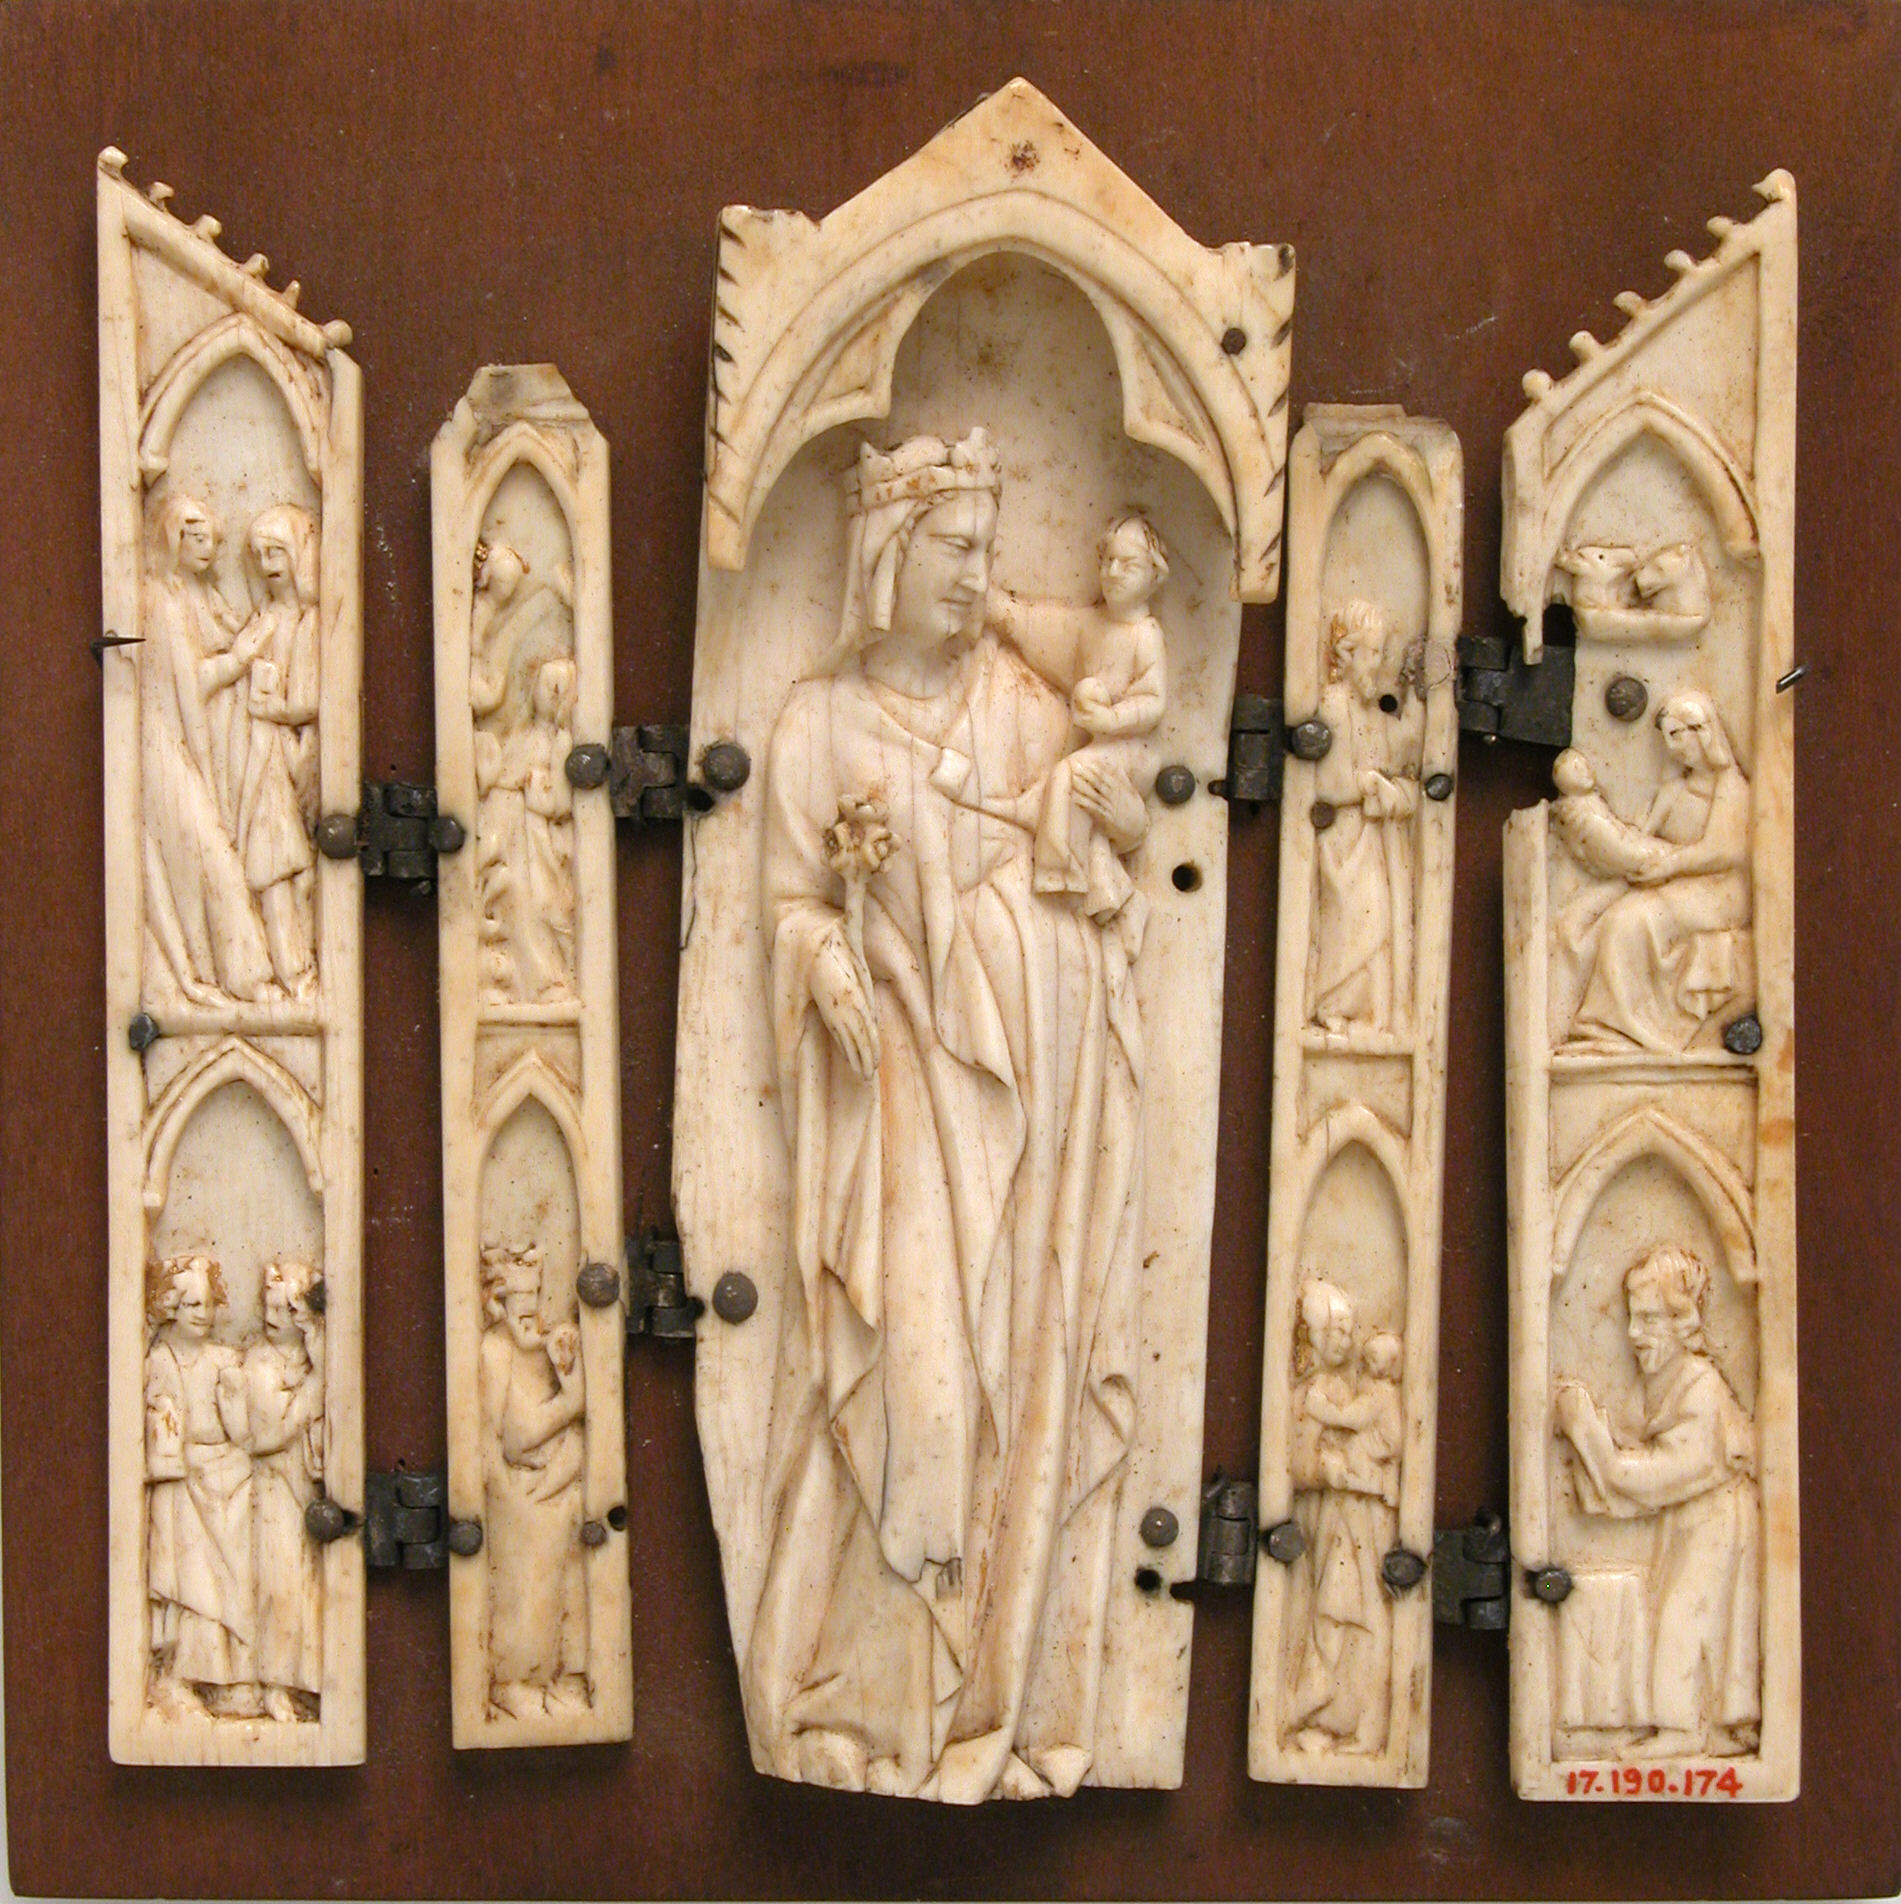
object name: folding shrine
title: Folding Shrine with the Virgin and Child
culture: french or italian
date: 1301-1400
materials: ivory, metal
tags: men,women